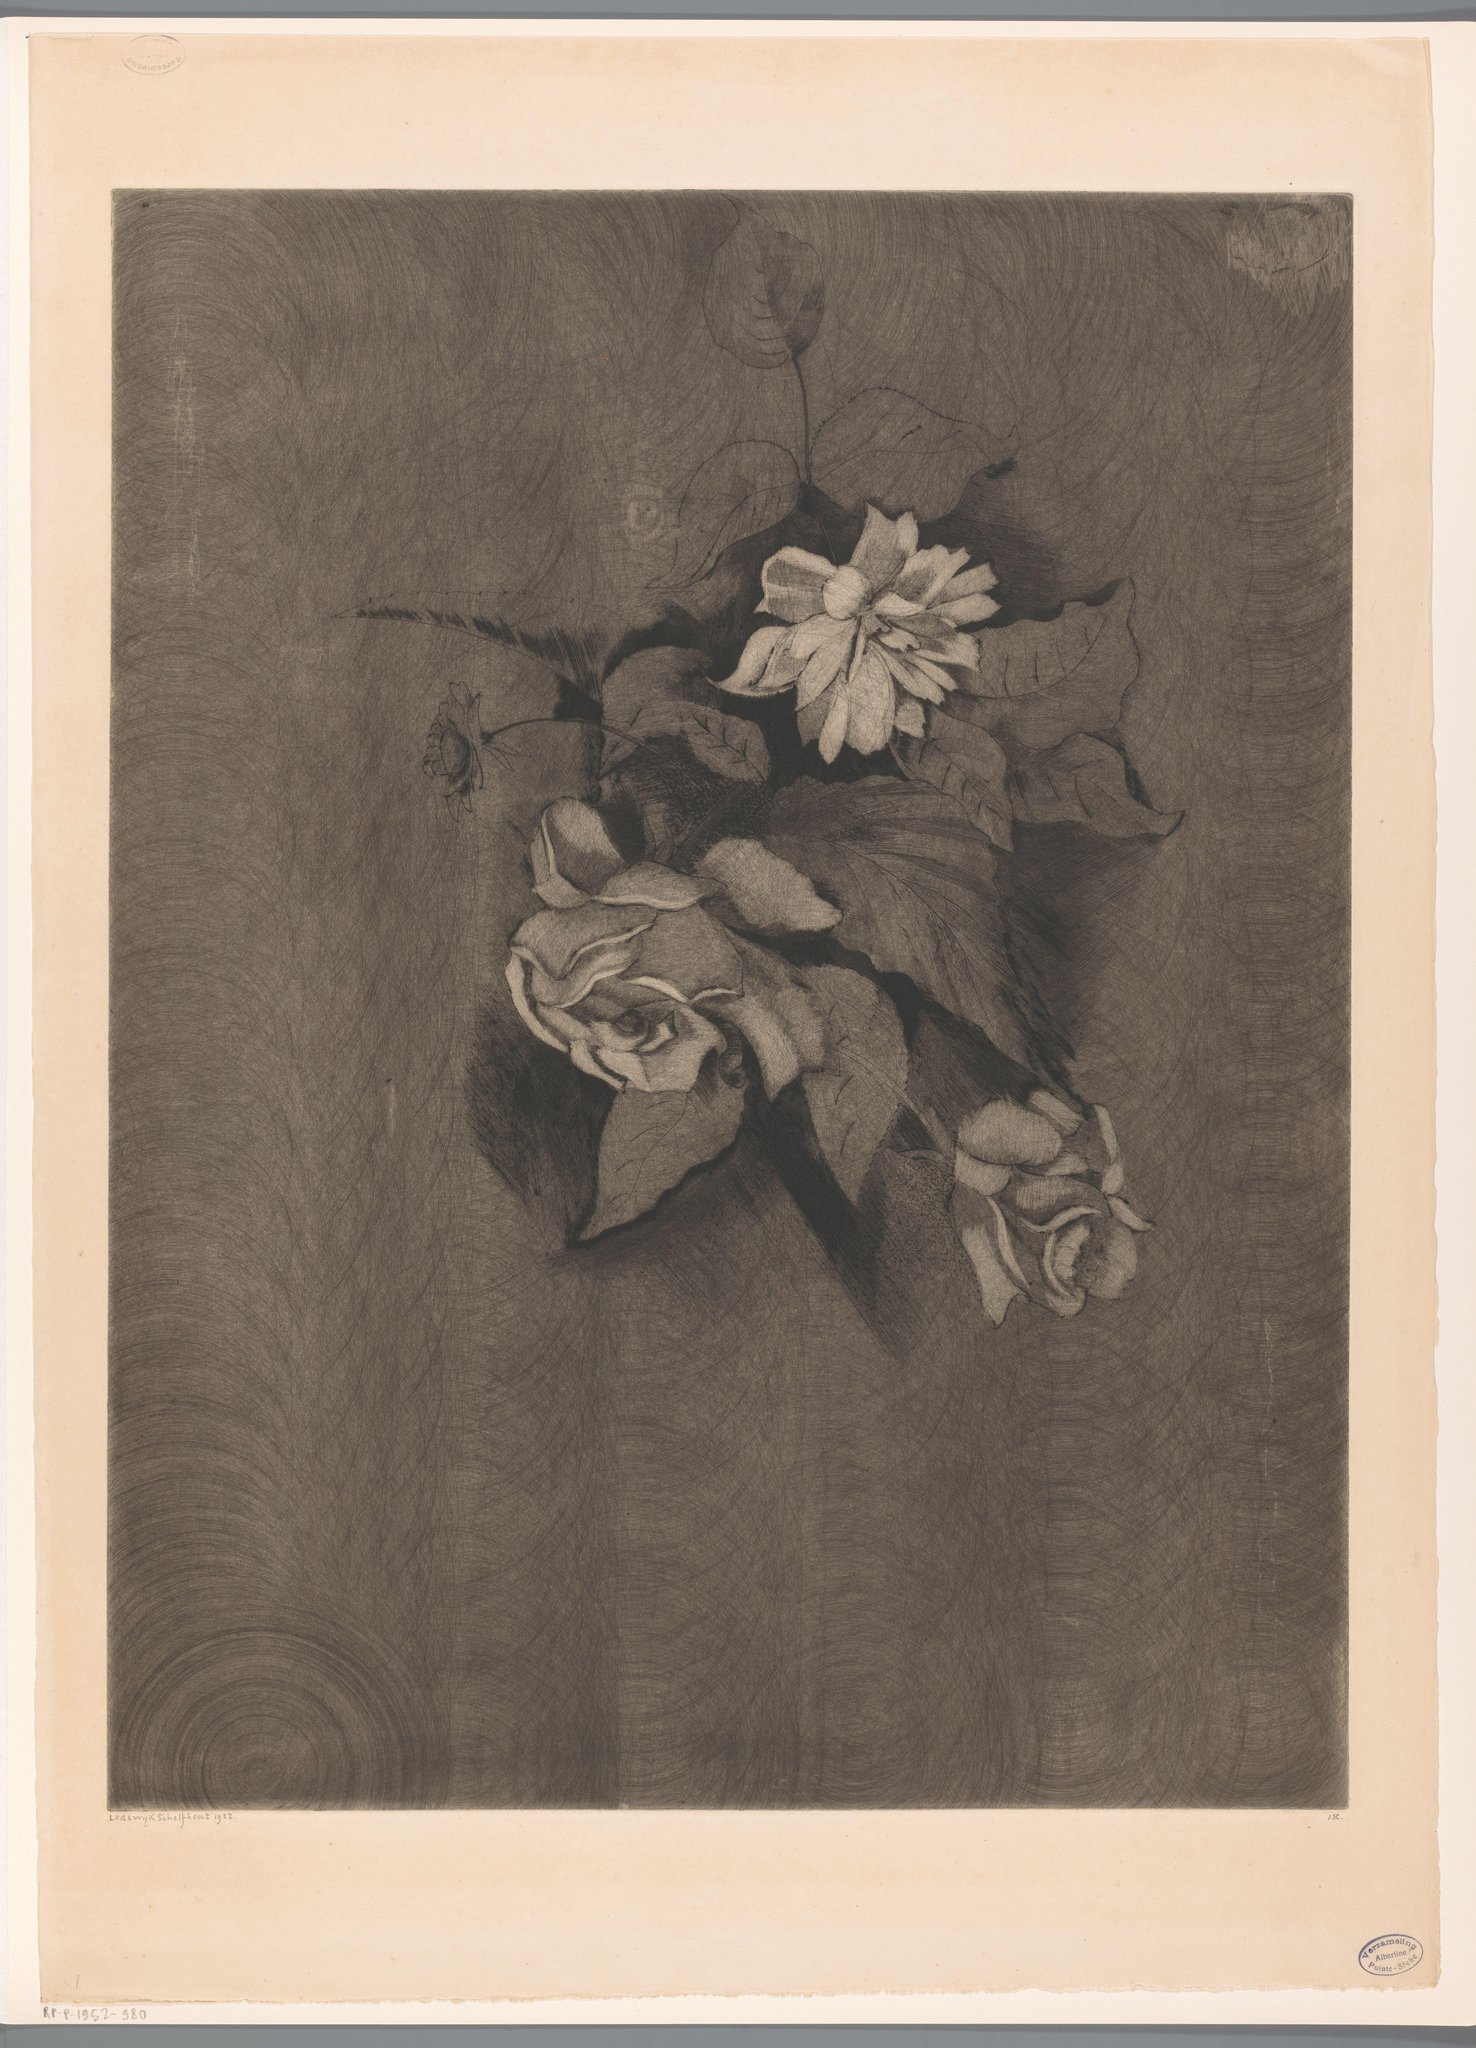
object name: print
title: Les Roses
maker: lodewijk schelfhout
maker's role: draughtsman, print maker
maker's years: 1881-1943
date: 1922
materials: paper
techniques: drypoint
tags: flowers: rose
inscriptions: collector's mark: Lugt 2760, collector's mark: Lugt 2228, collector's mark: Lugt 5i